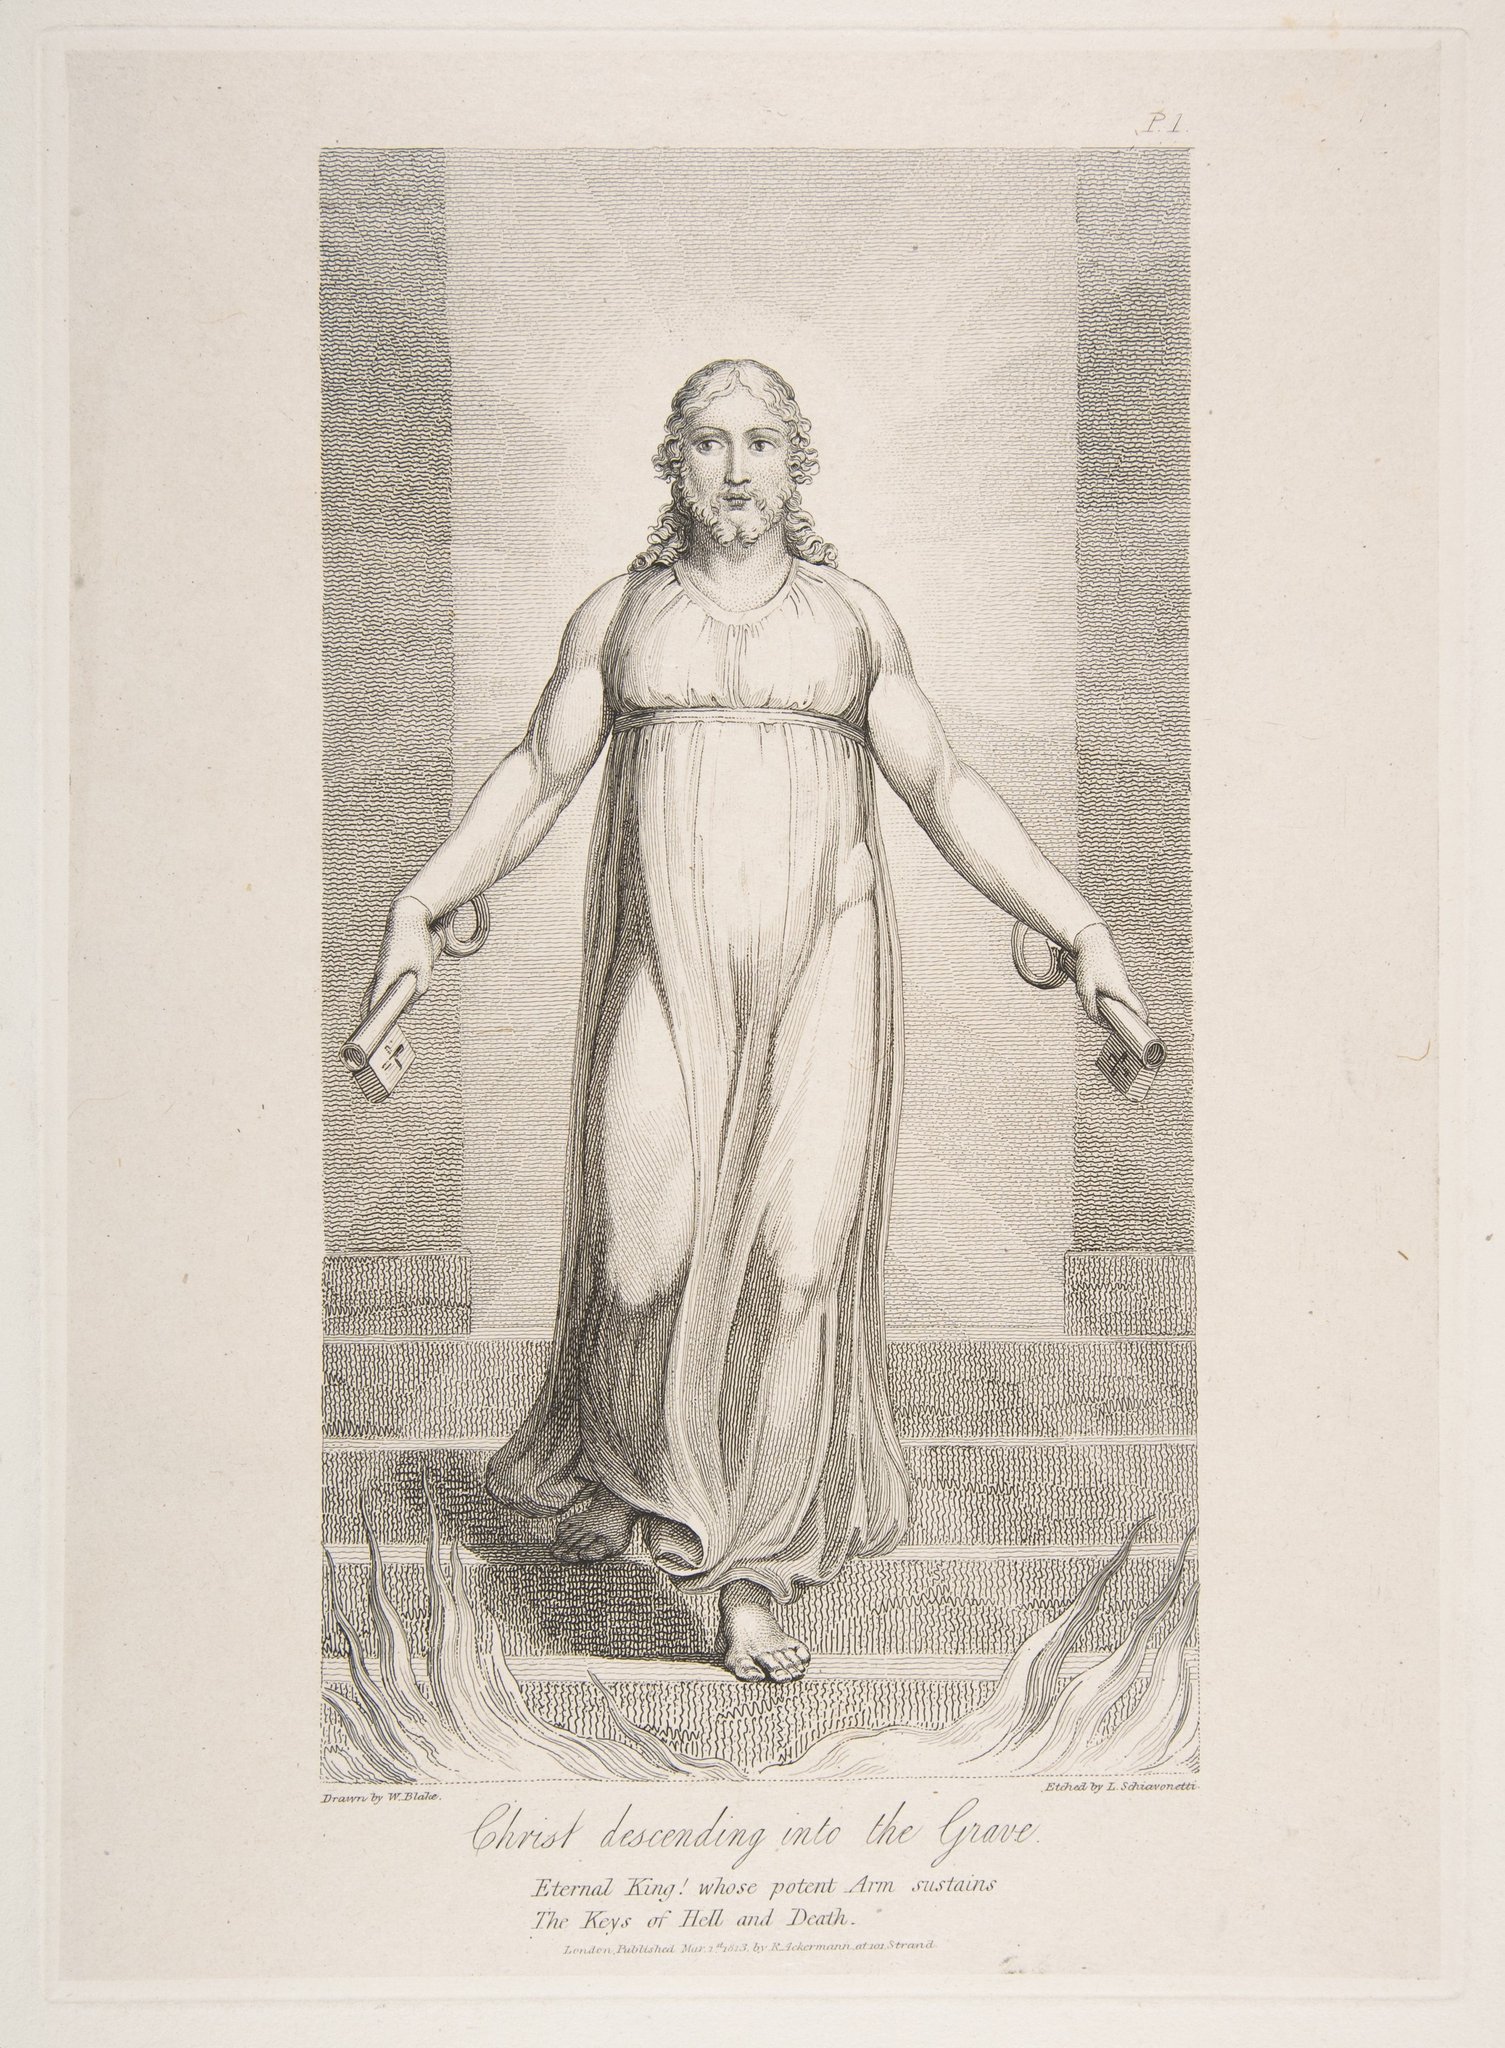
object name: print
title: Christ Descending into the Grave, from "The Grave," a Poem by Robert Blair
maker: william blake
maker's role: artist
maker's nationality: british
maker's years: 1757-1827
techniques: engraving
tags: christ